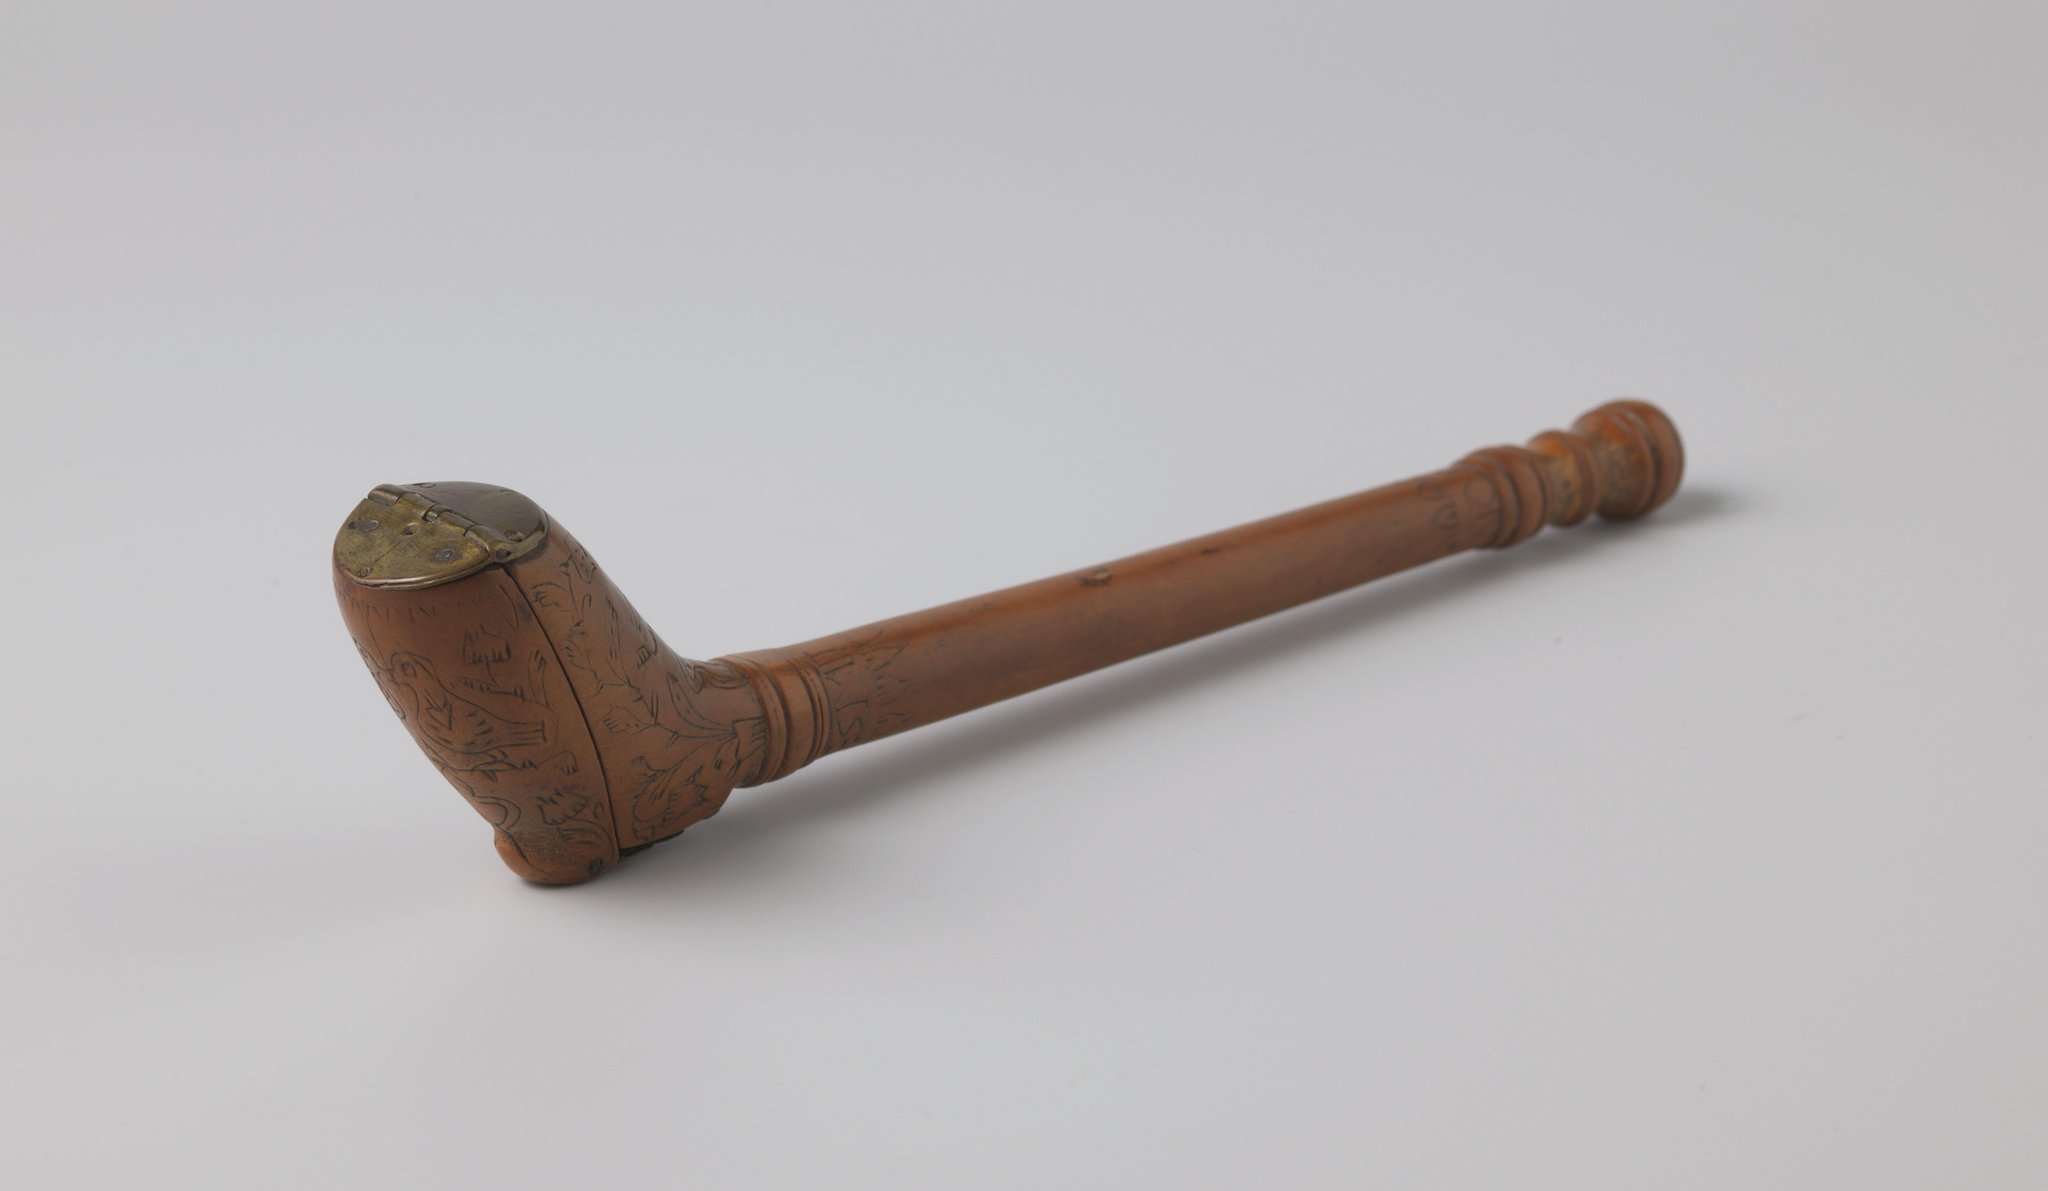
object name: pipe holder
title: Pijpenfoedraal met pijp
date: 1733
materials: wood, brass, clay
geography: netherlands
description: Pijpenfoudraal van palmhout met jaartal 1733 en opschrift BEDACH ALESMIT. Met koperbeslag. Er in gouds pijpje op de ketel de Nederlandse Maagd en een visserman. Gedeelte van de steel ontbreekt.